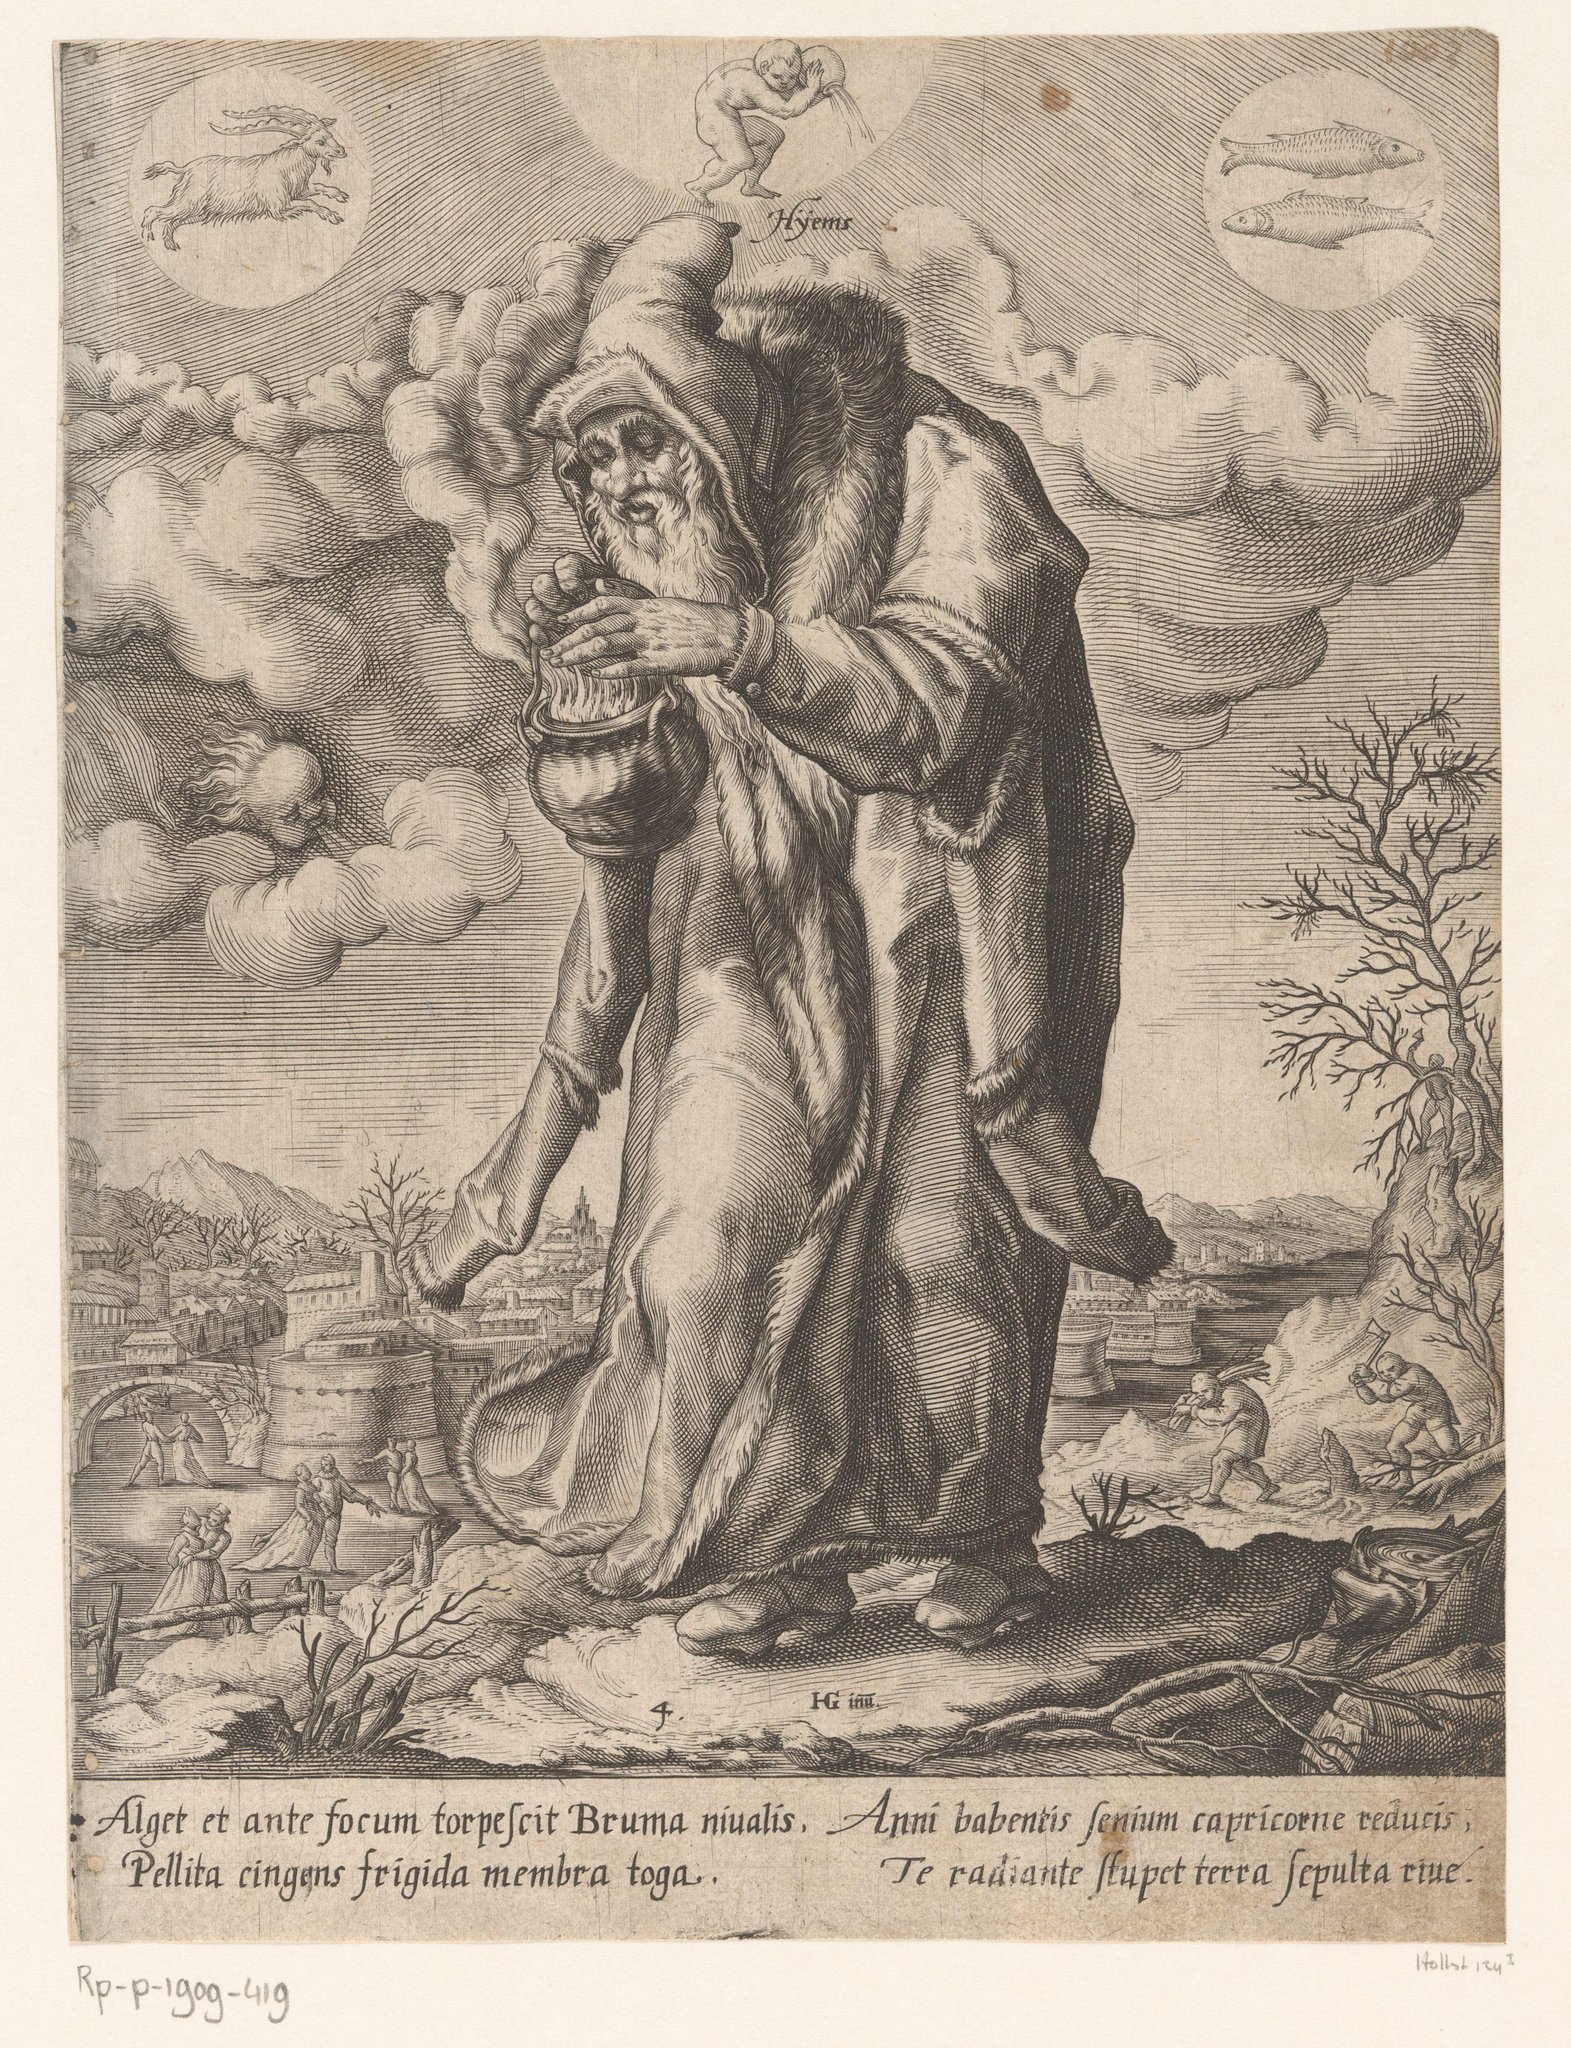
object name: print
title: De vier seizoenen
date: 1585-1638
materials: paper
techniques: engraving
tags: wind as a human face, blowing with rounded cheeks, winter, 'hyems'; 'inverno' (ripa), skates (winter sports), zodiacal signs of the winter season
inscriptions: collector's mark: Lugt 2228